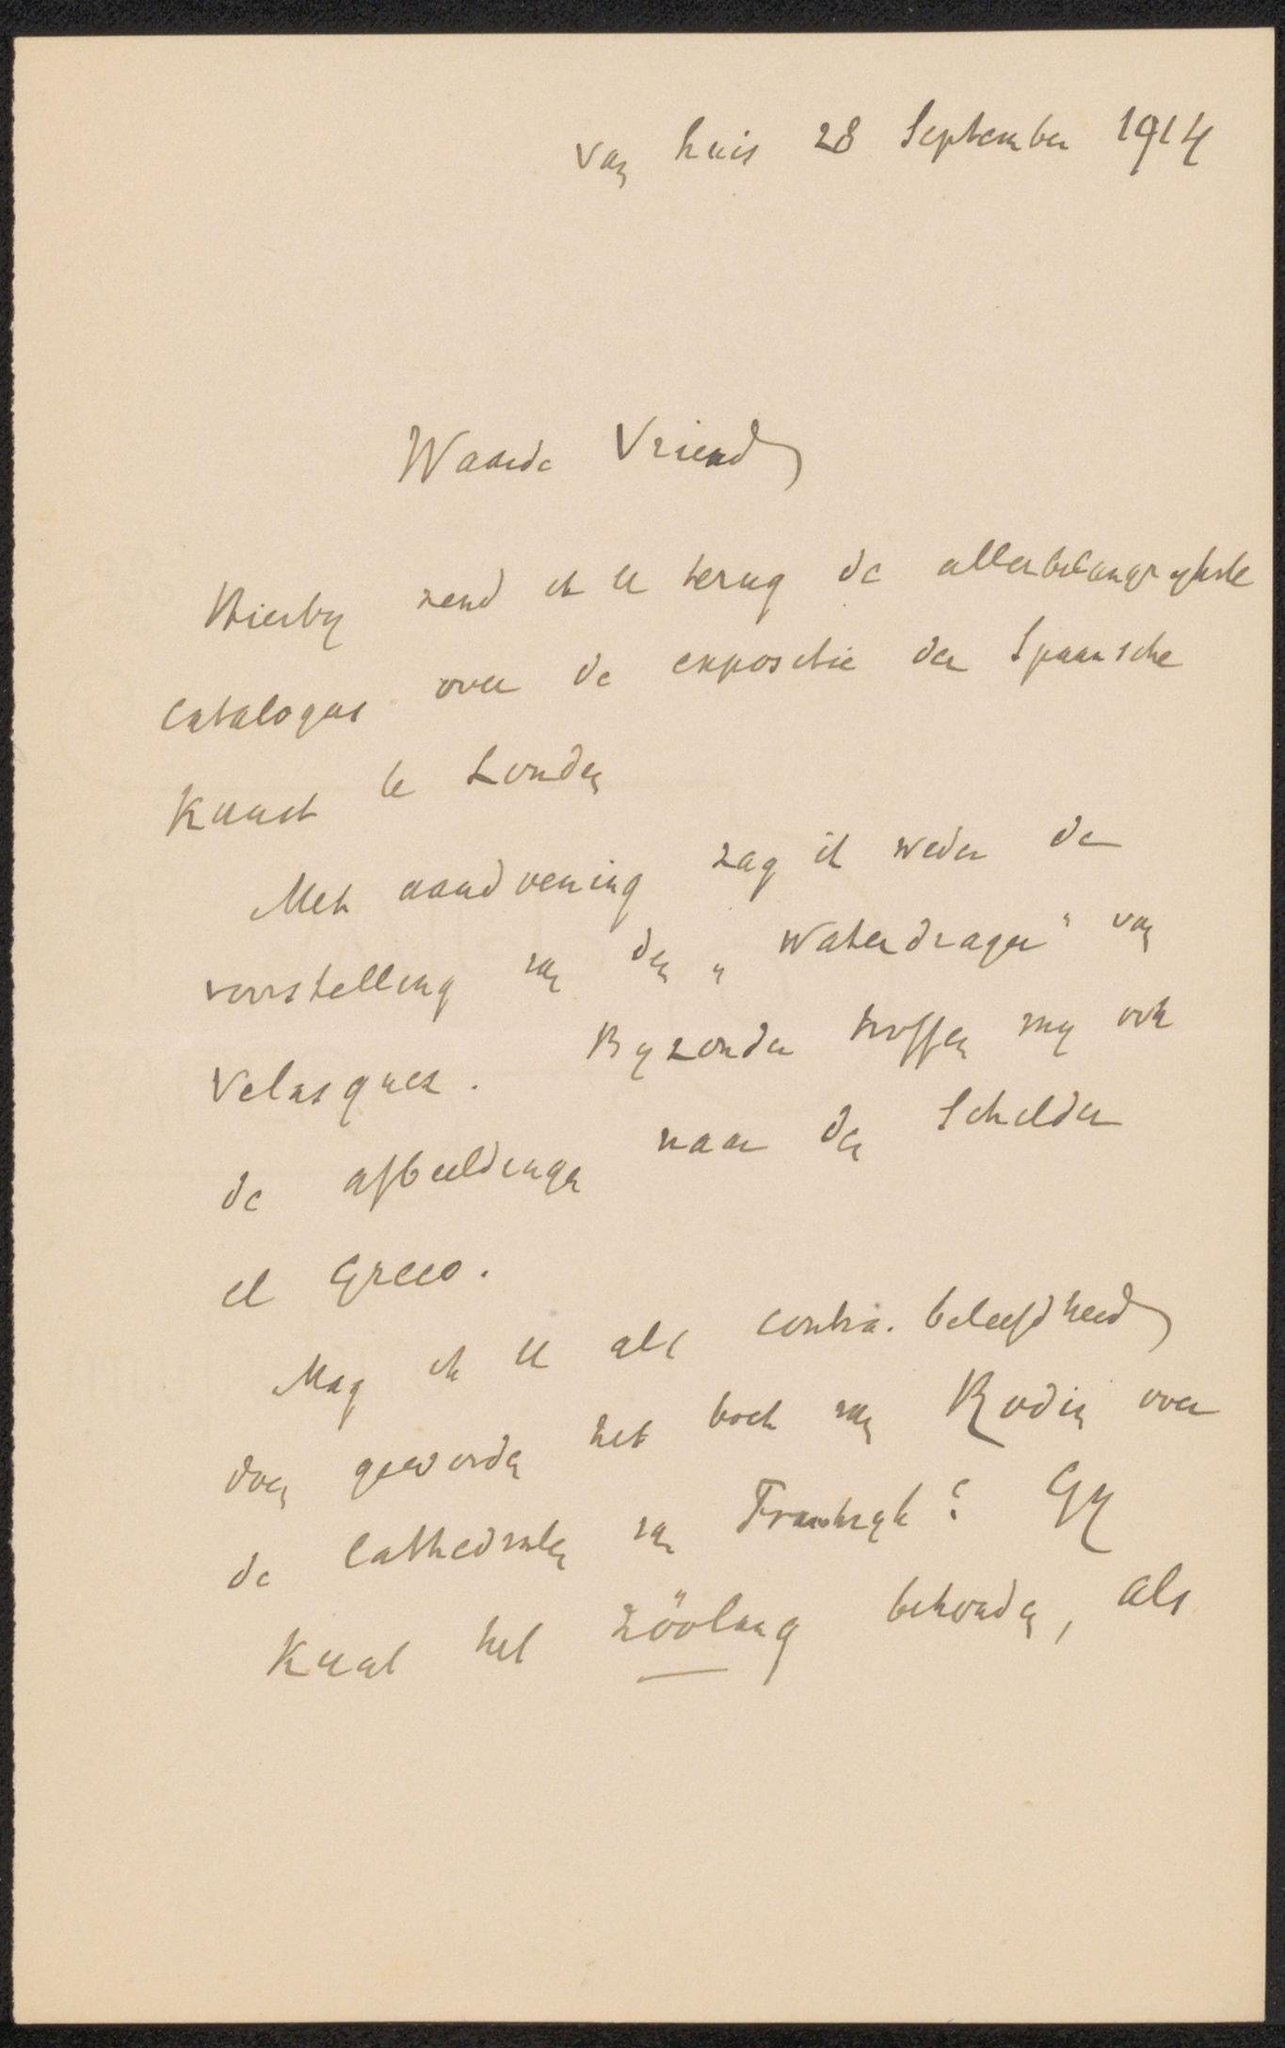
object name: letter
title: Brief aan August Allebé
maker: hendrick peter godfried quack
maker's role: econoom, geschiedschrijver, hoogleraar, jurist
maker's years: 1834-1917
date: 1914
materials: ink, paper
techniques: pen, writing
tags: amsterdam, august allebé, sevilla, painter, diego rodriguez de silva y velázquez, paris, print maker, draughtsman, auguste rodin, el greco, exhibition ~ art, printed matter, london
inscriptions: watermark